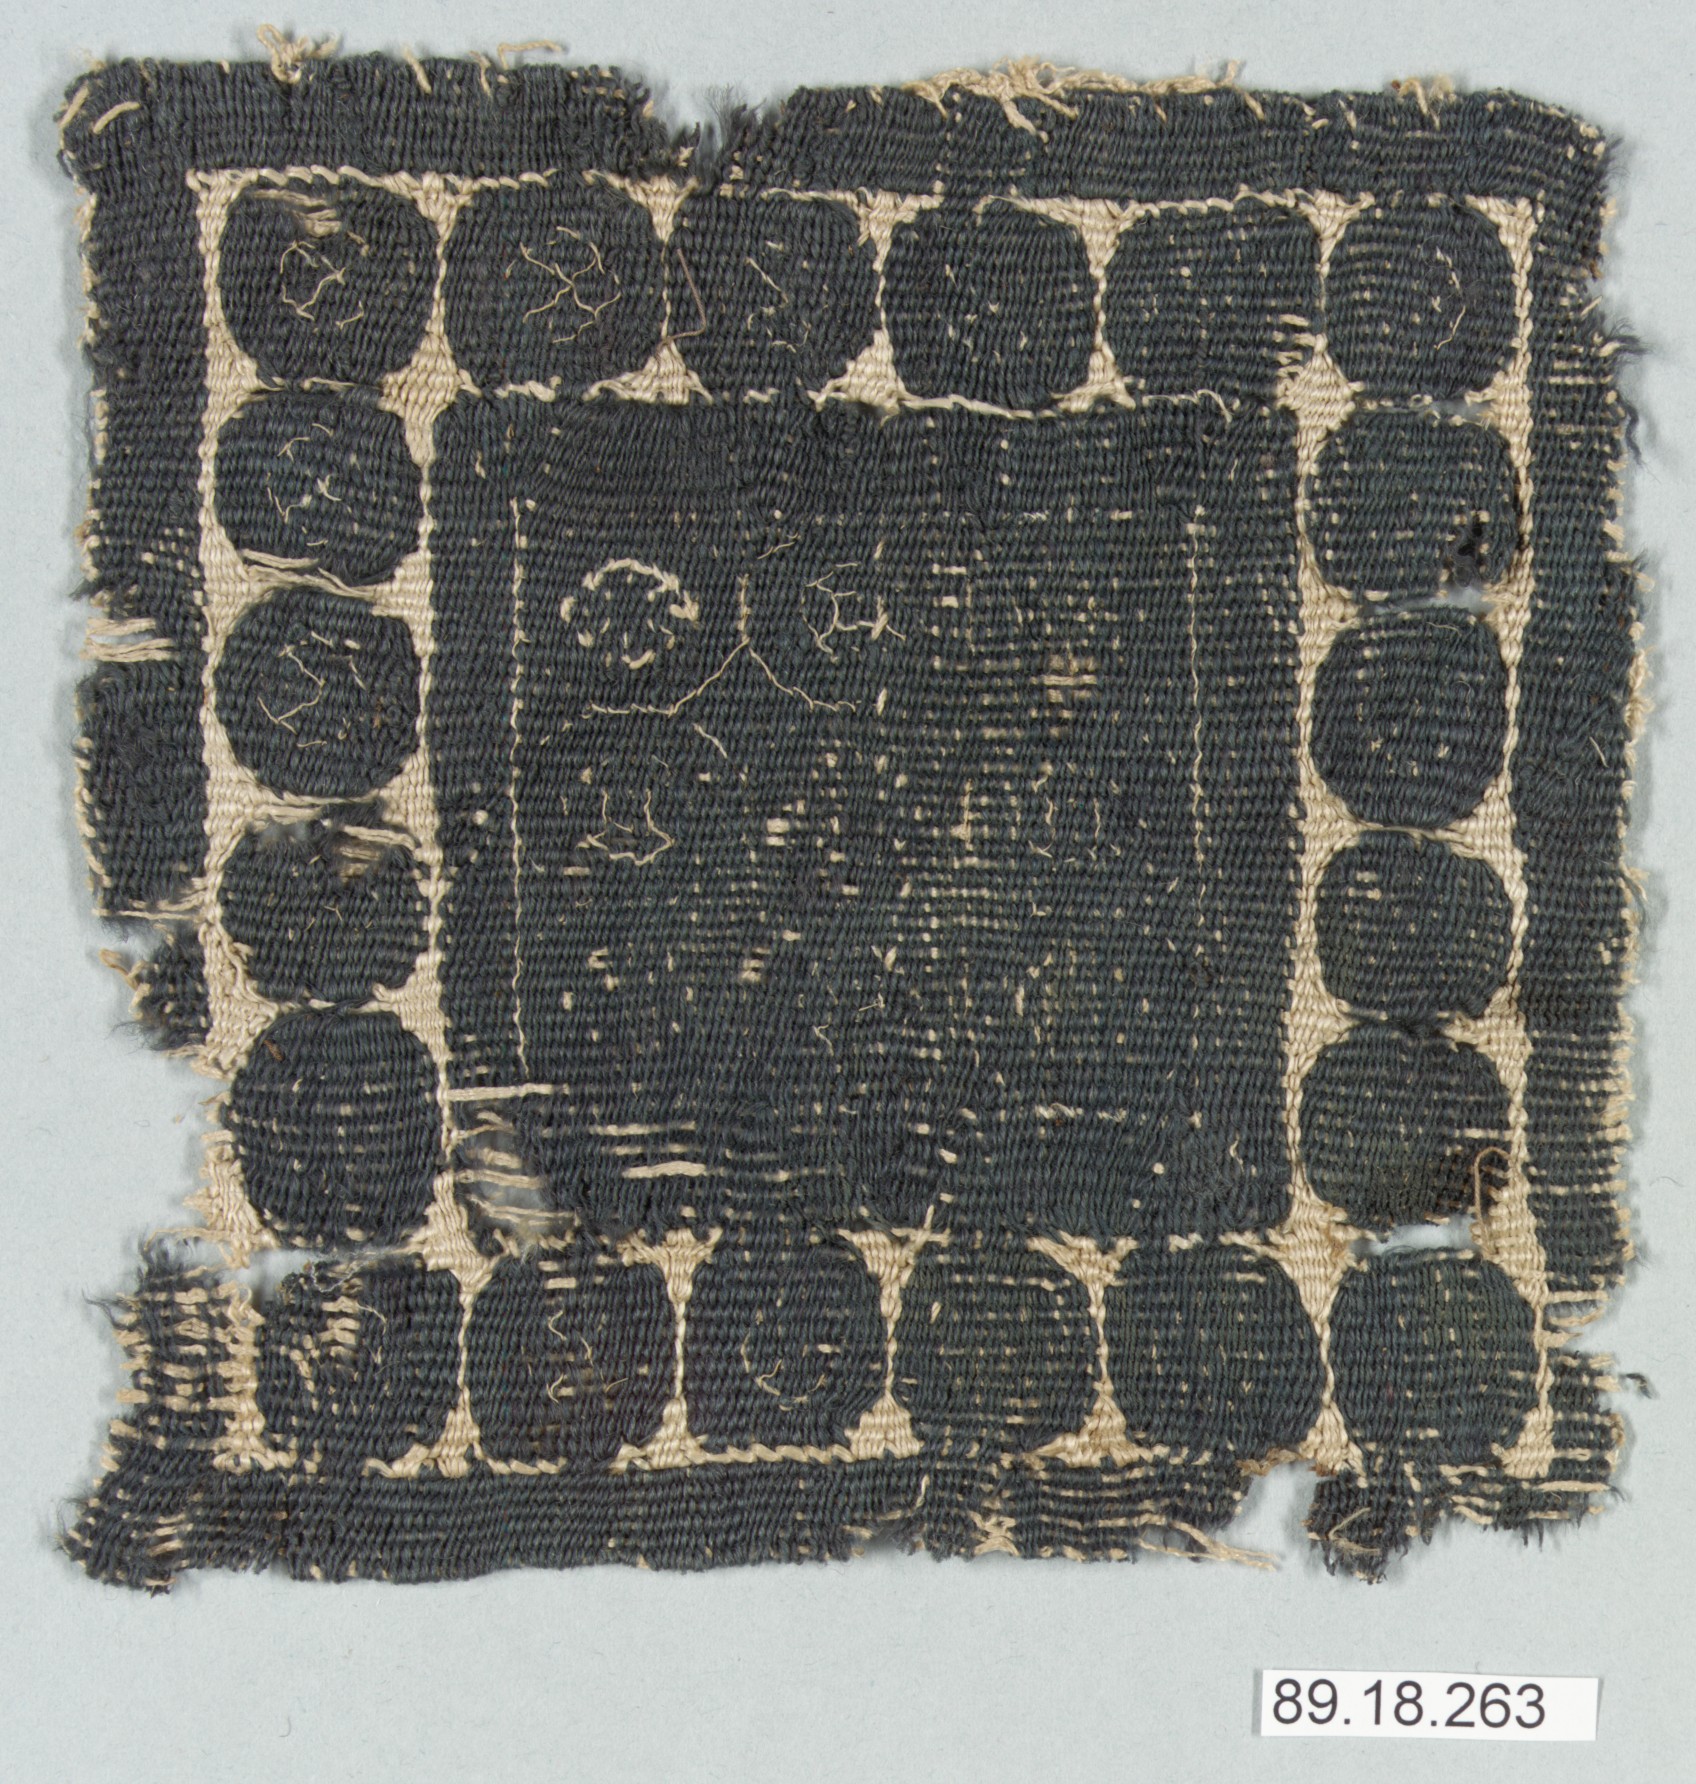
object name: textile fragment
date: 201-400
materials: linen, wool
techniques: weave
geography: egypt